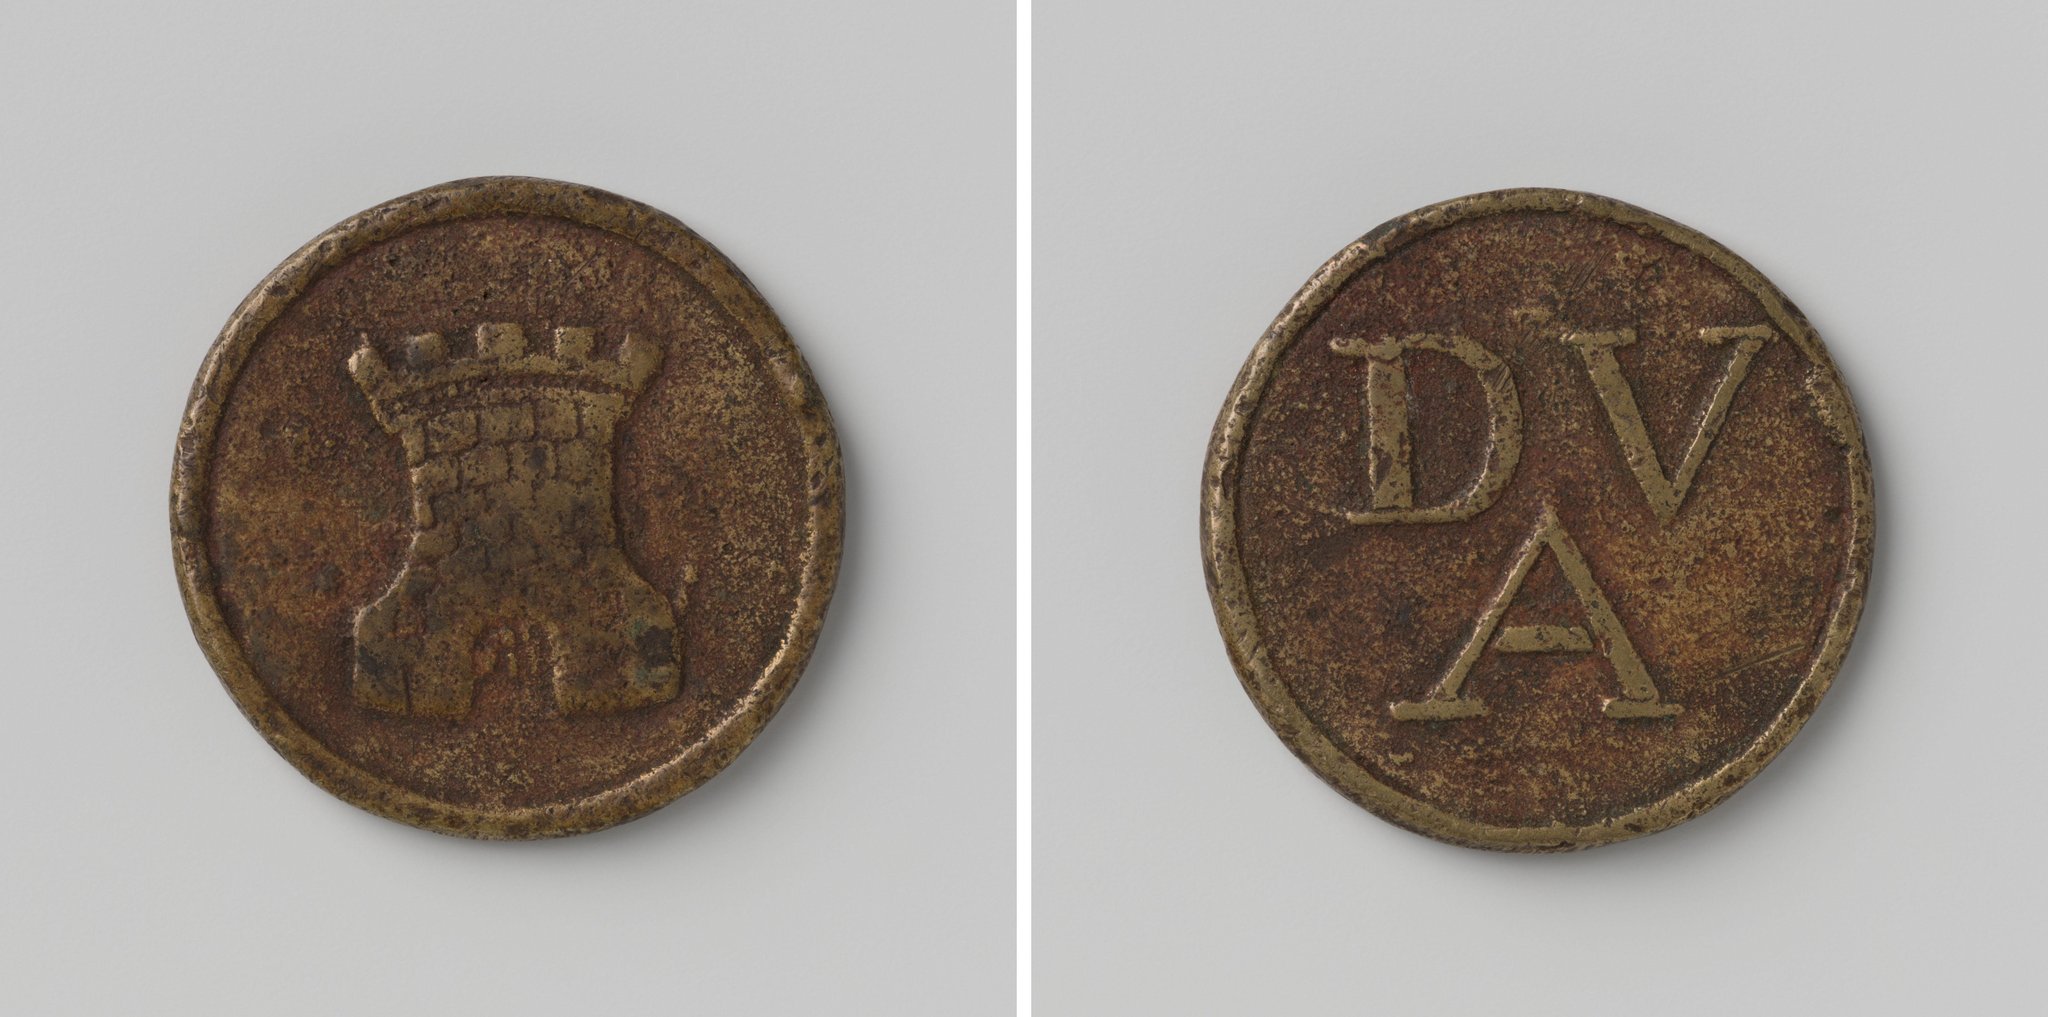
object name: armenloodje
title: Diaconie van Alkmaar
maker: Anonymous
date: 1600-1800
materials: brass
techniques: casting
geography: alkmaar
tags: alkmaar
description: Messing penning. Voorzijde: burcht. Keerzijde: letters D en V, boven letter A.